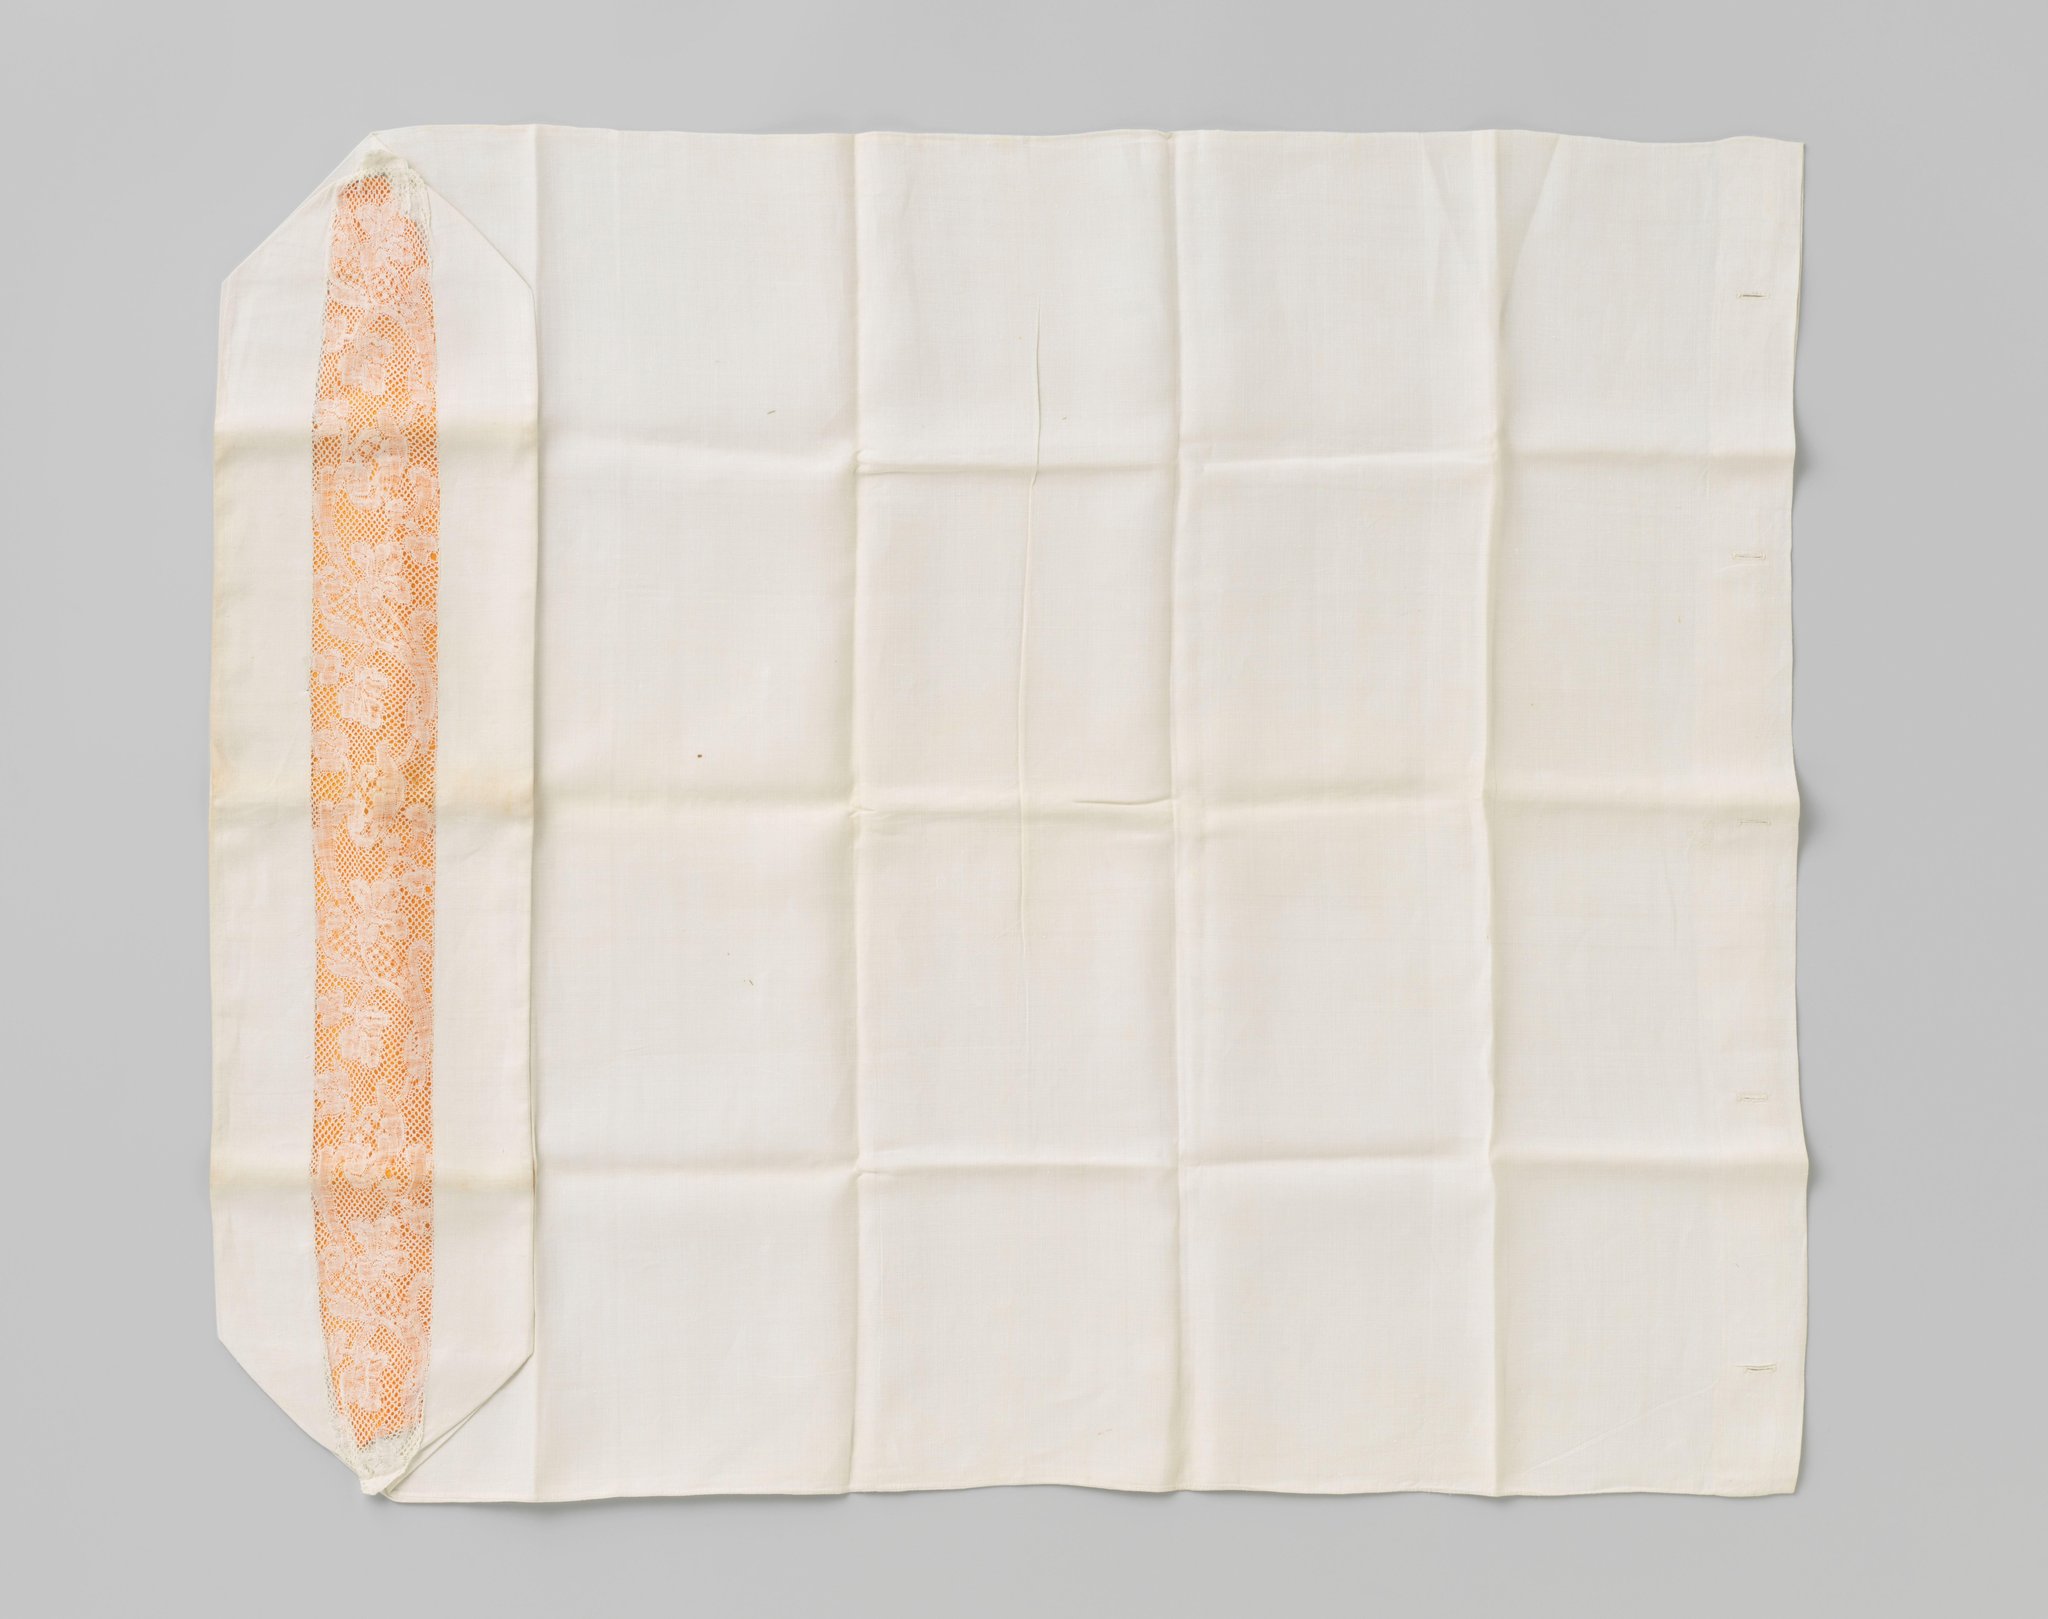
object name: sloop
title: Sloop van linnen met entre-deux van kloskant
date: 1750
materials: linen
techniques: lace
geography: netherlands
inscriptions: mark: ‘SW 6’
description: Sloop van linnen met entre-deux van brede kloskant met décor van bloemranken. Gemerkt in het midden van de korte zijde met S.W.6 in bindgat. Met later vernieuwde machinale zomen en knoopsgaten.